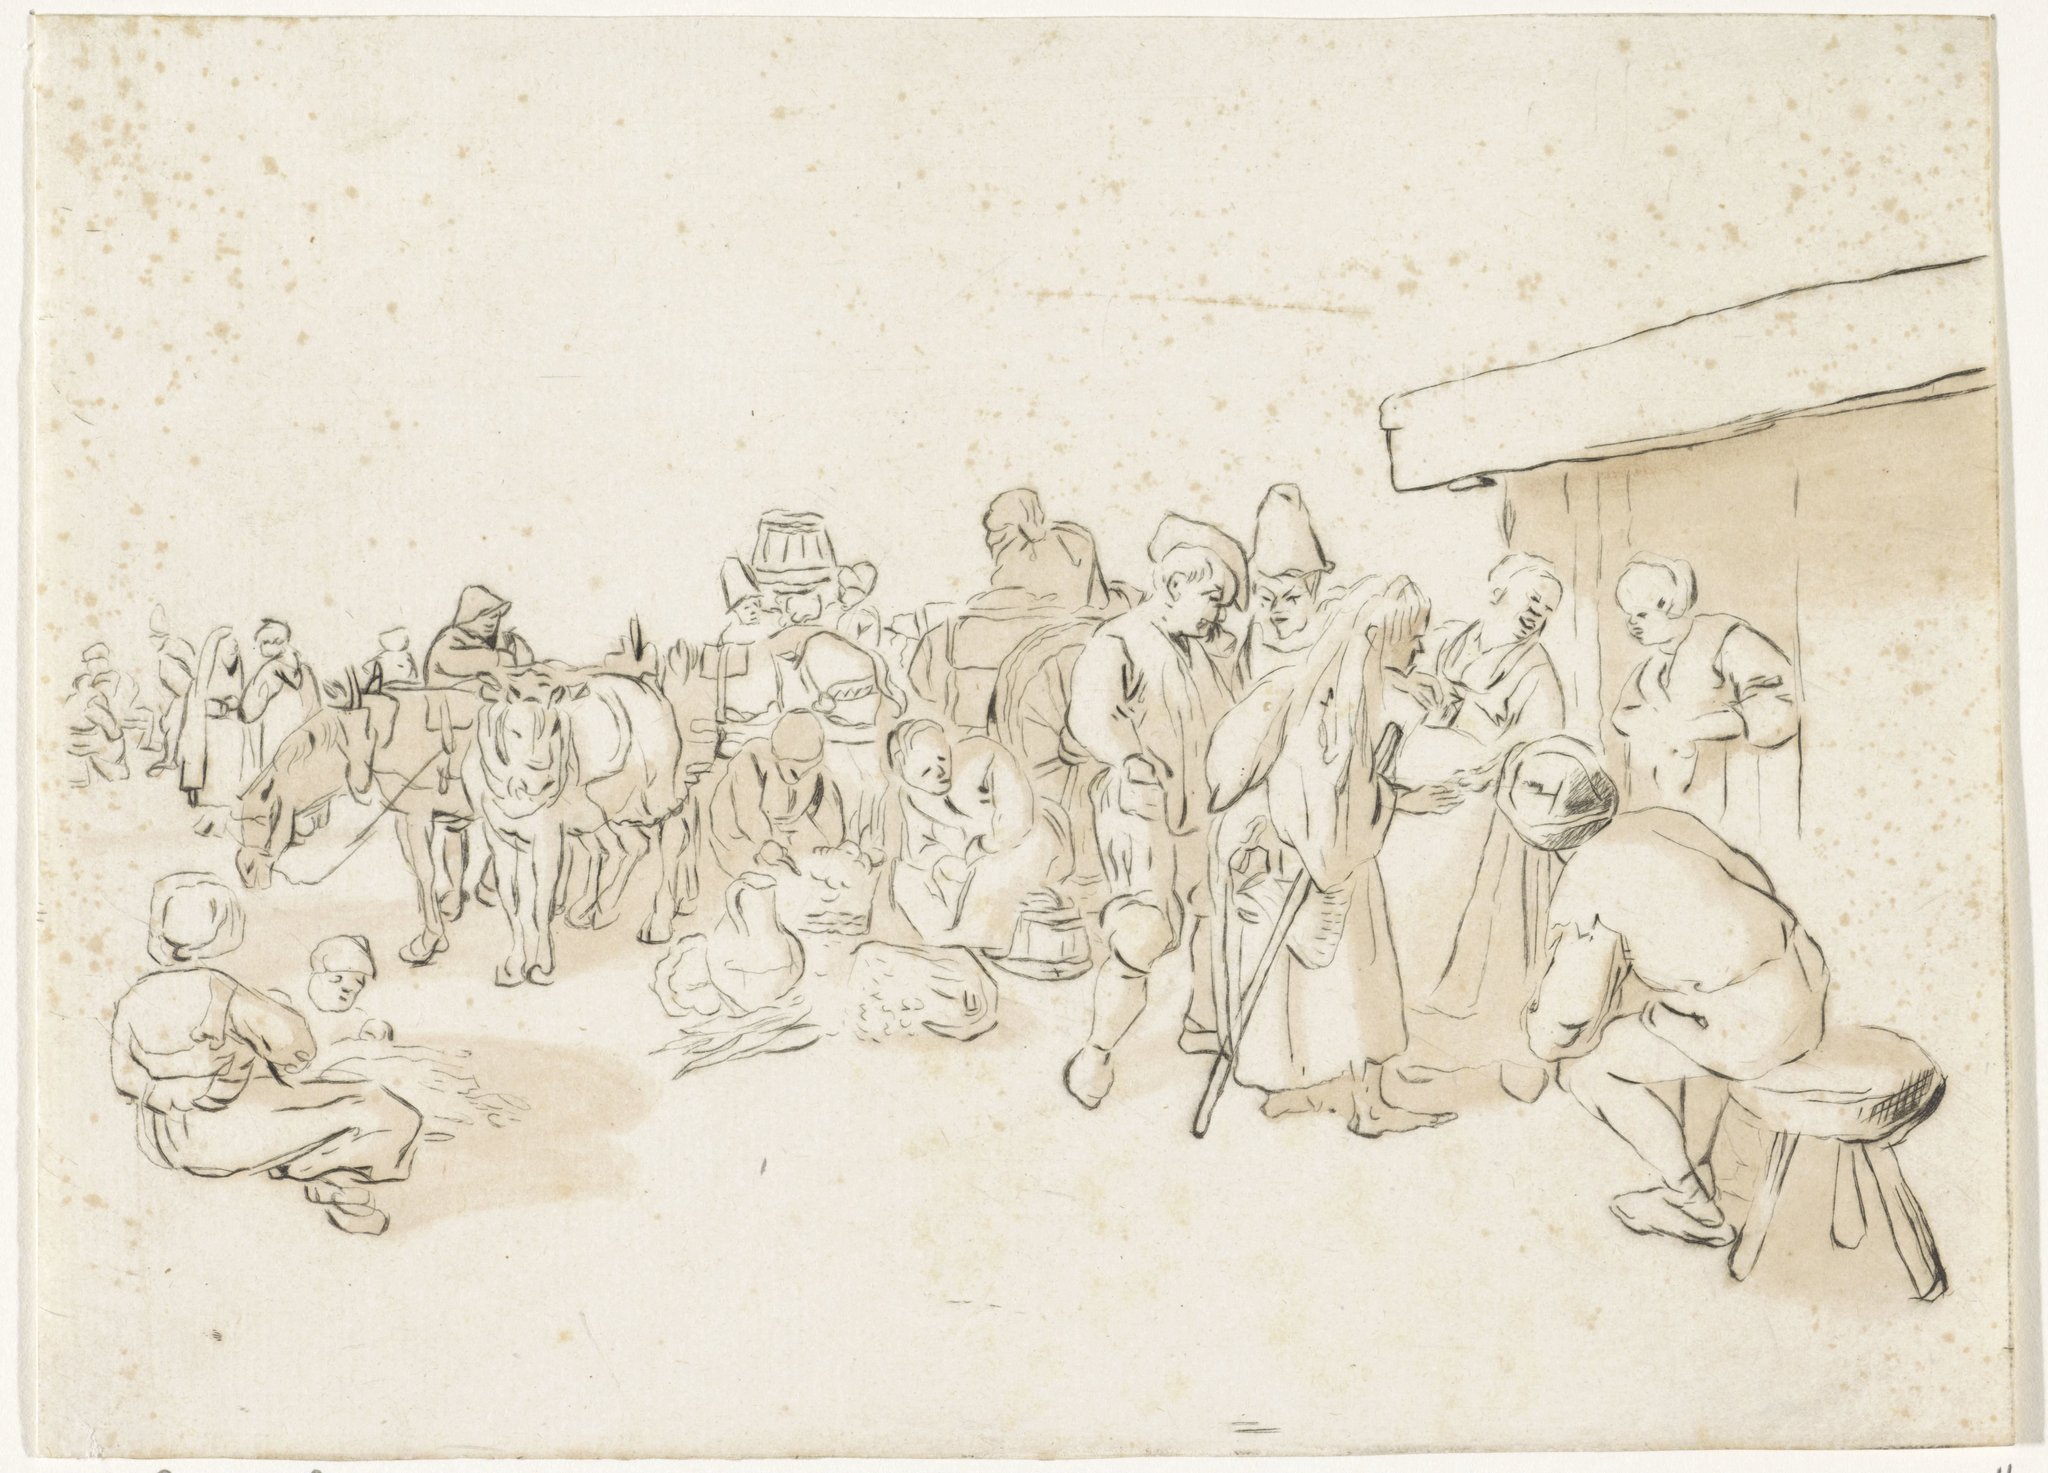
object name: print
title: Markt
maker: willem van wessem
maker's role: print maker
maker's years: 1725-1787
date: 1735-1787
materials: paper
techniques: etching, hand coloring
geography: amsterdam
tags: horse, market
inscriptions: collector's mark: Lugt 240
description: Een mensenmenigte op een markt. Rechts een vrouw leunend op een onderdeur.